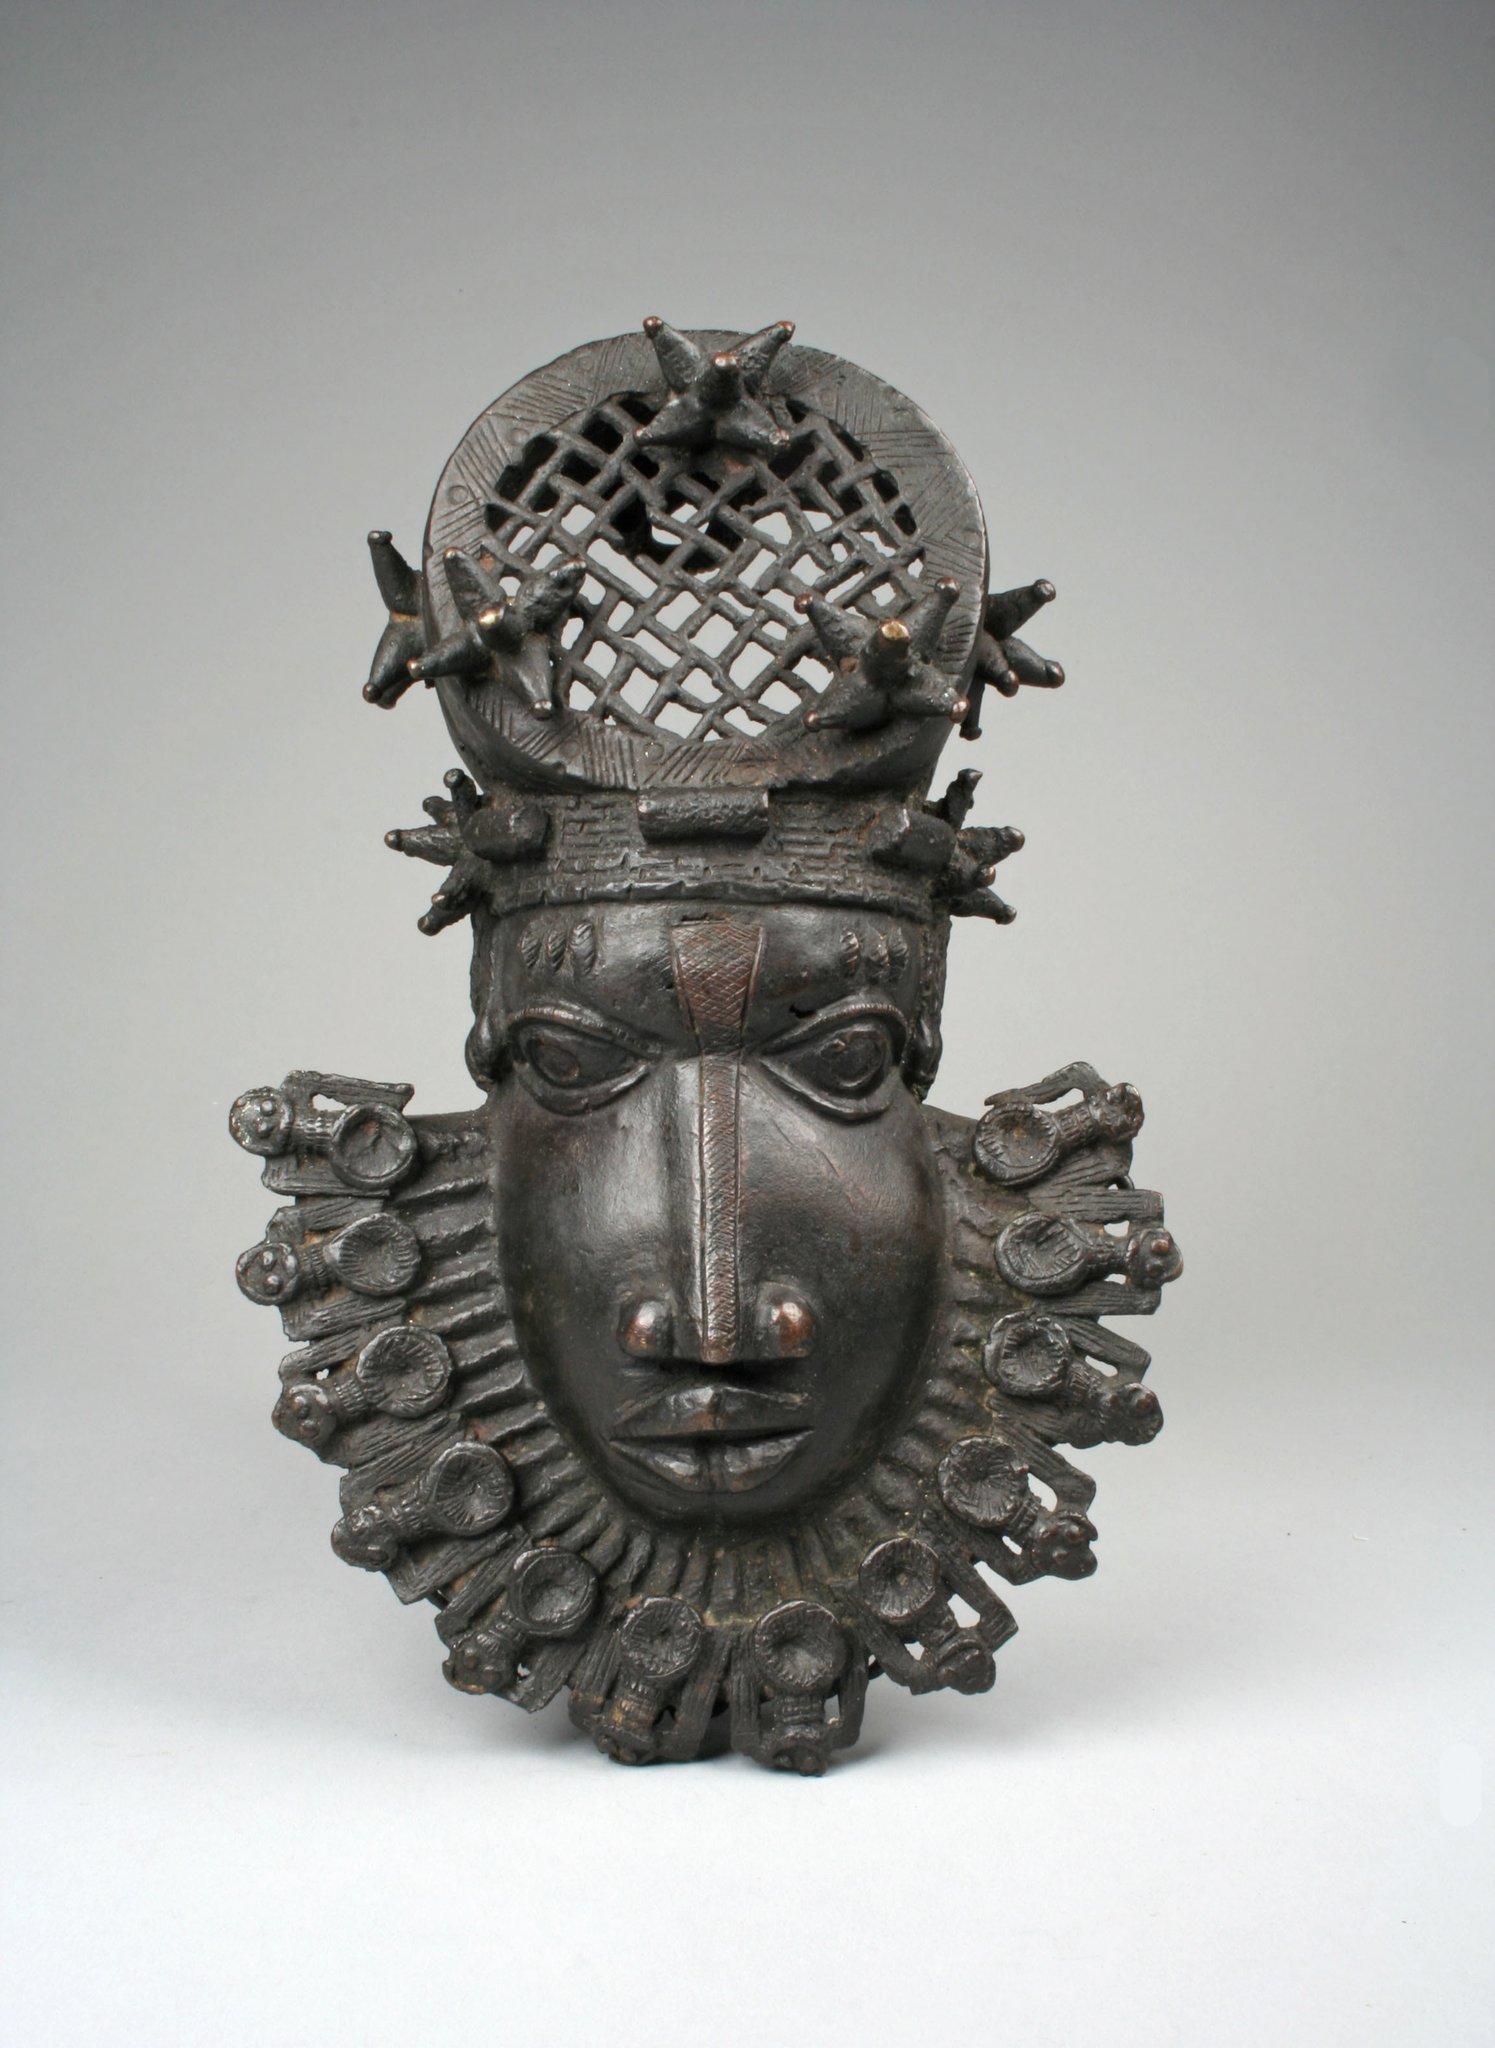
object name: ornament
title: Hip Ornament: Face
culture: edo period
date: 1501-1900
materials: brass, copper alloy, iron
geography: nigeria